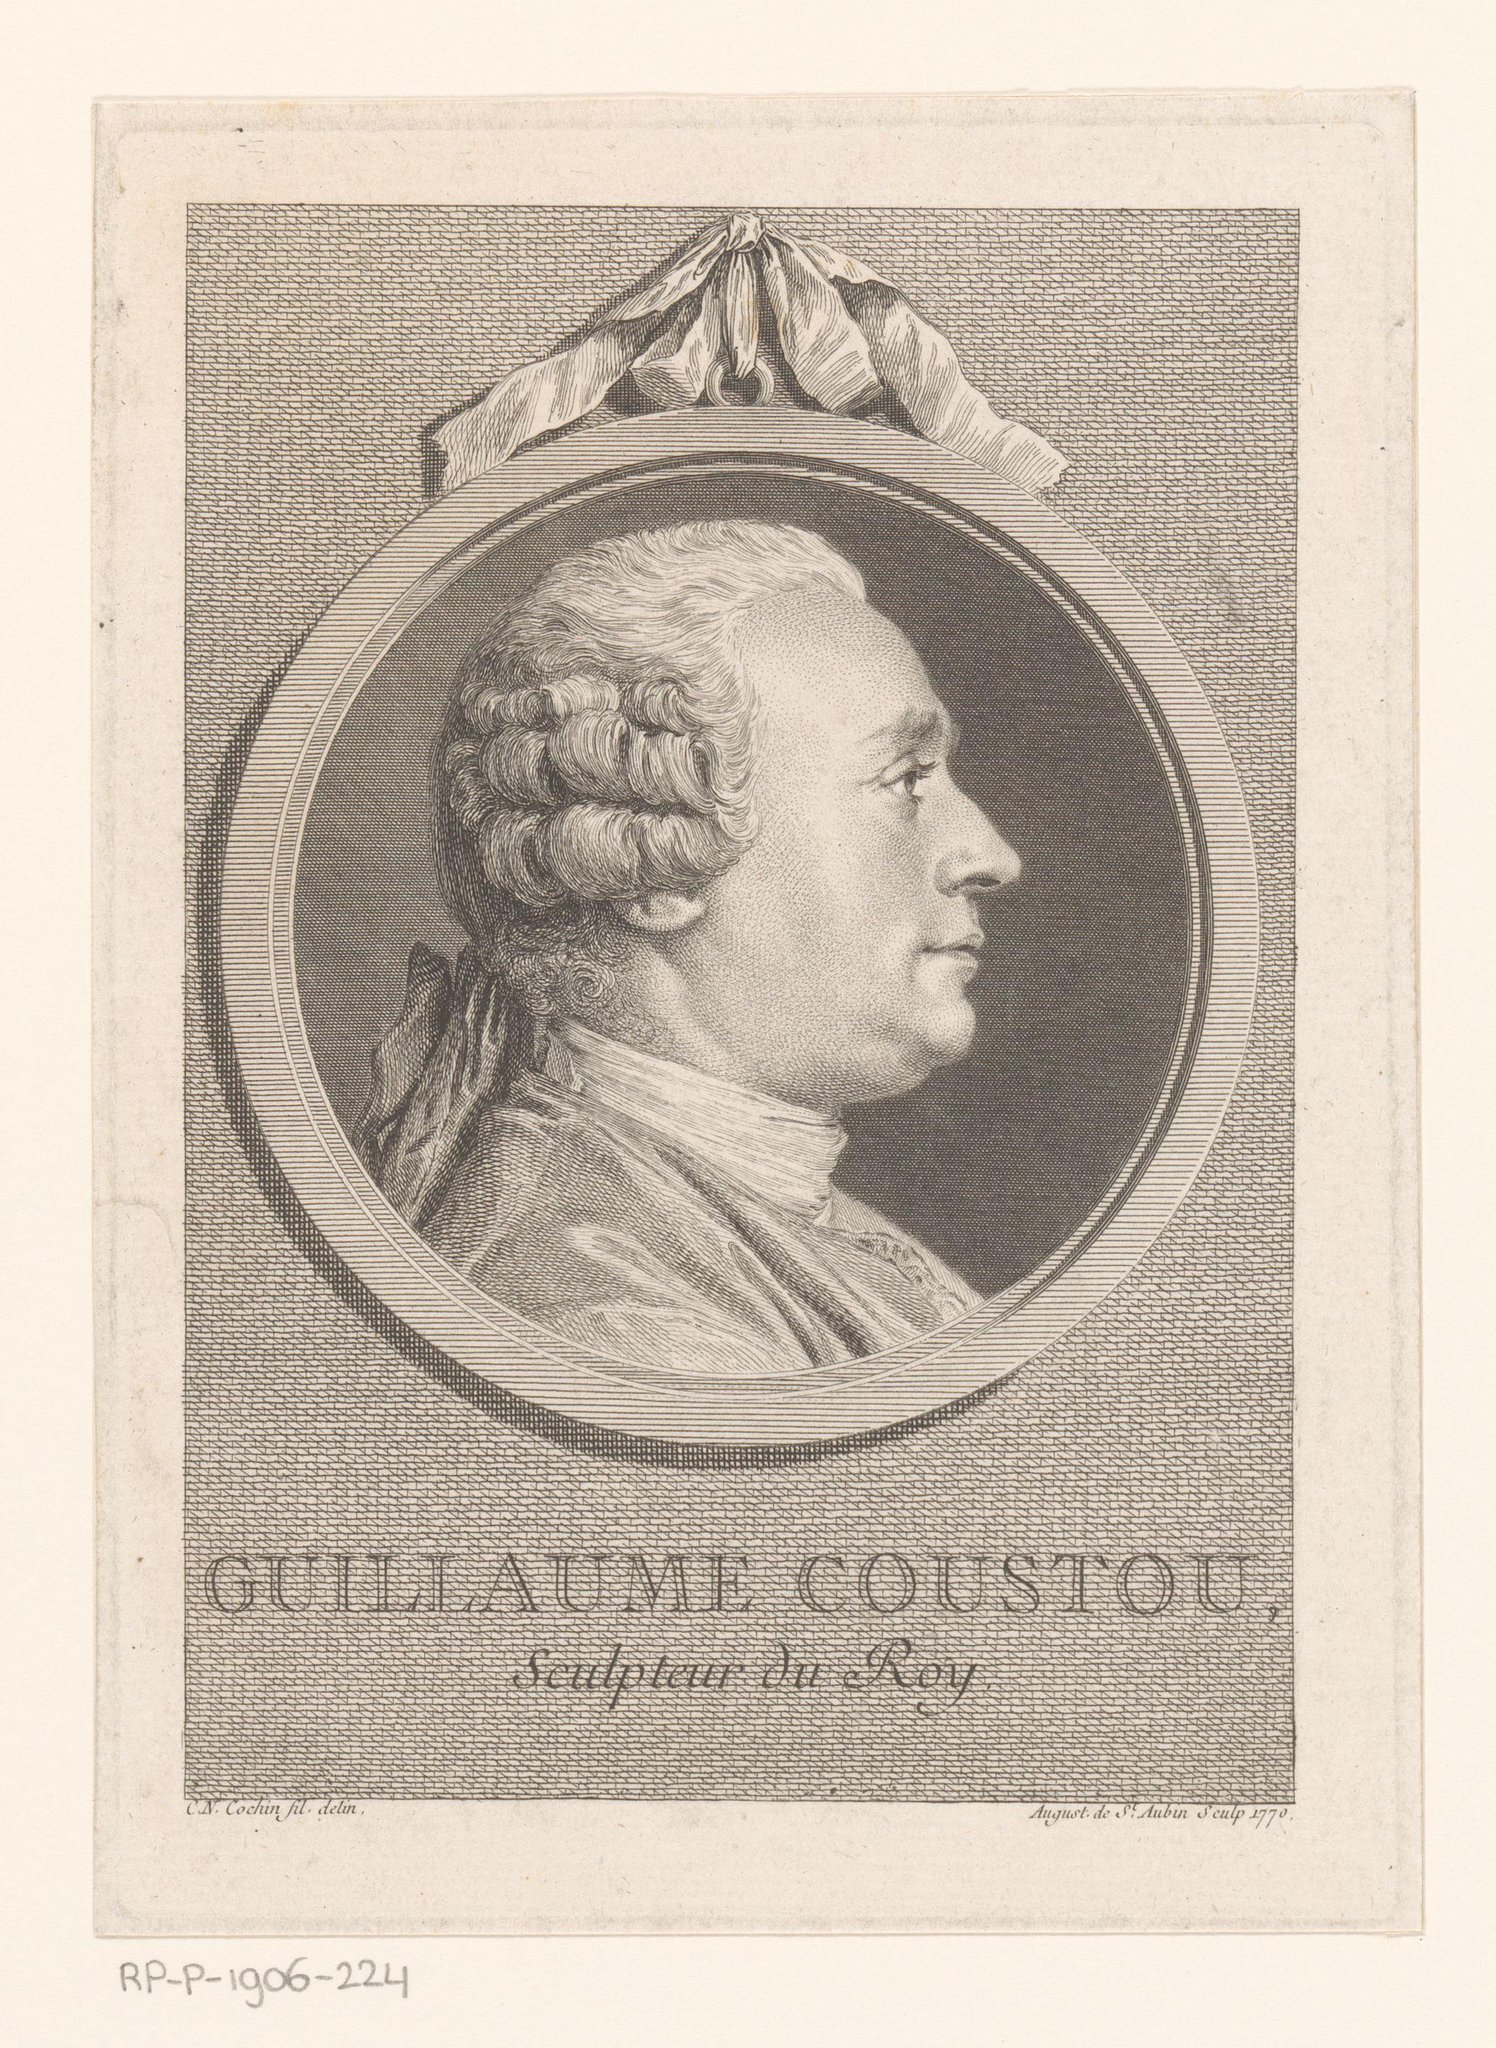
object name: print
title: Guillaume Coustou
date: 1770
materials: paper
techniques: engraving, etching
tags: sculptor, portrait, self-portrait of sculptor, historical persons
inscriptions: collector's mark: Lugt 2228